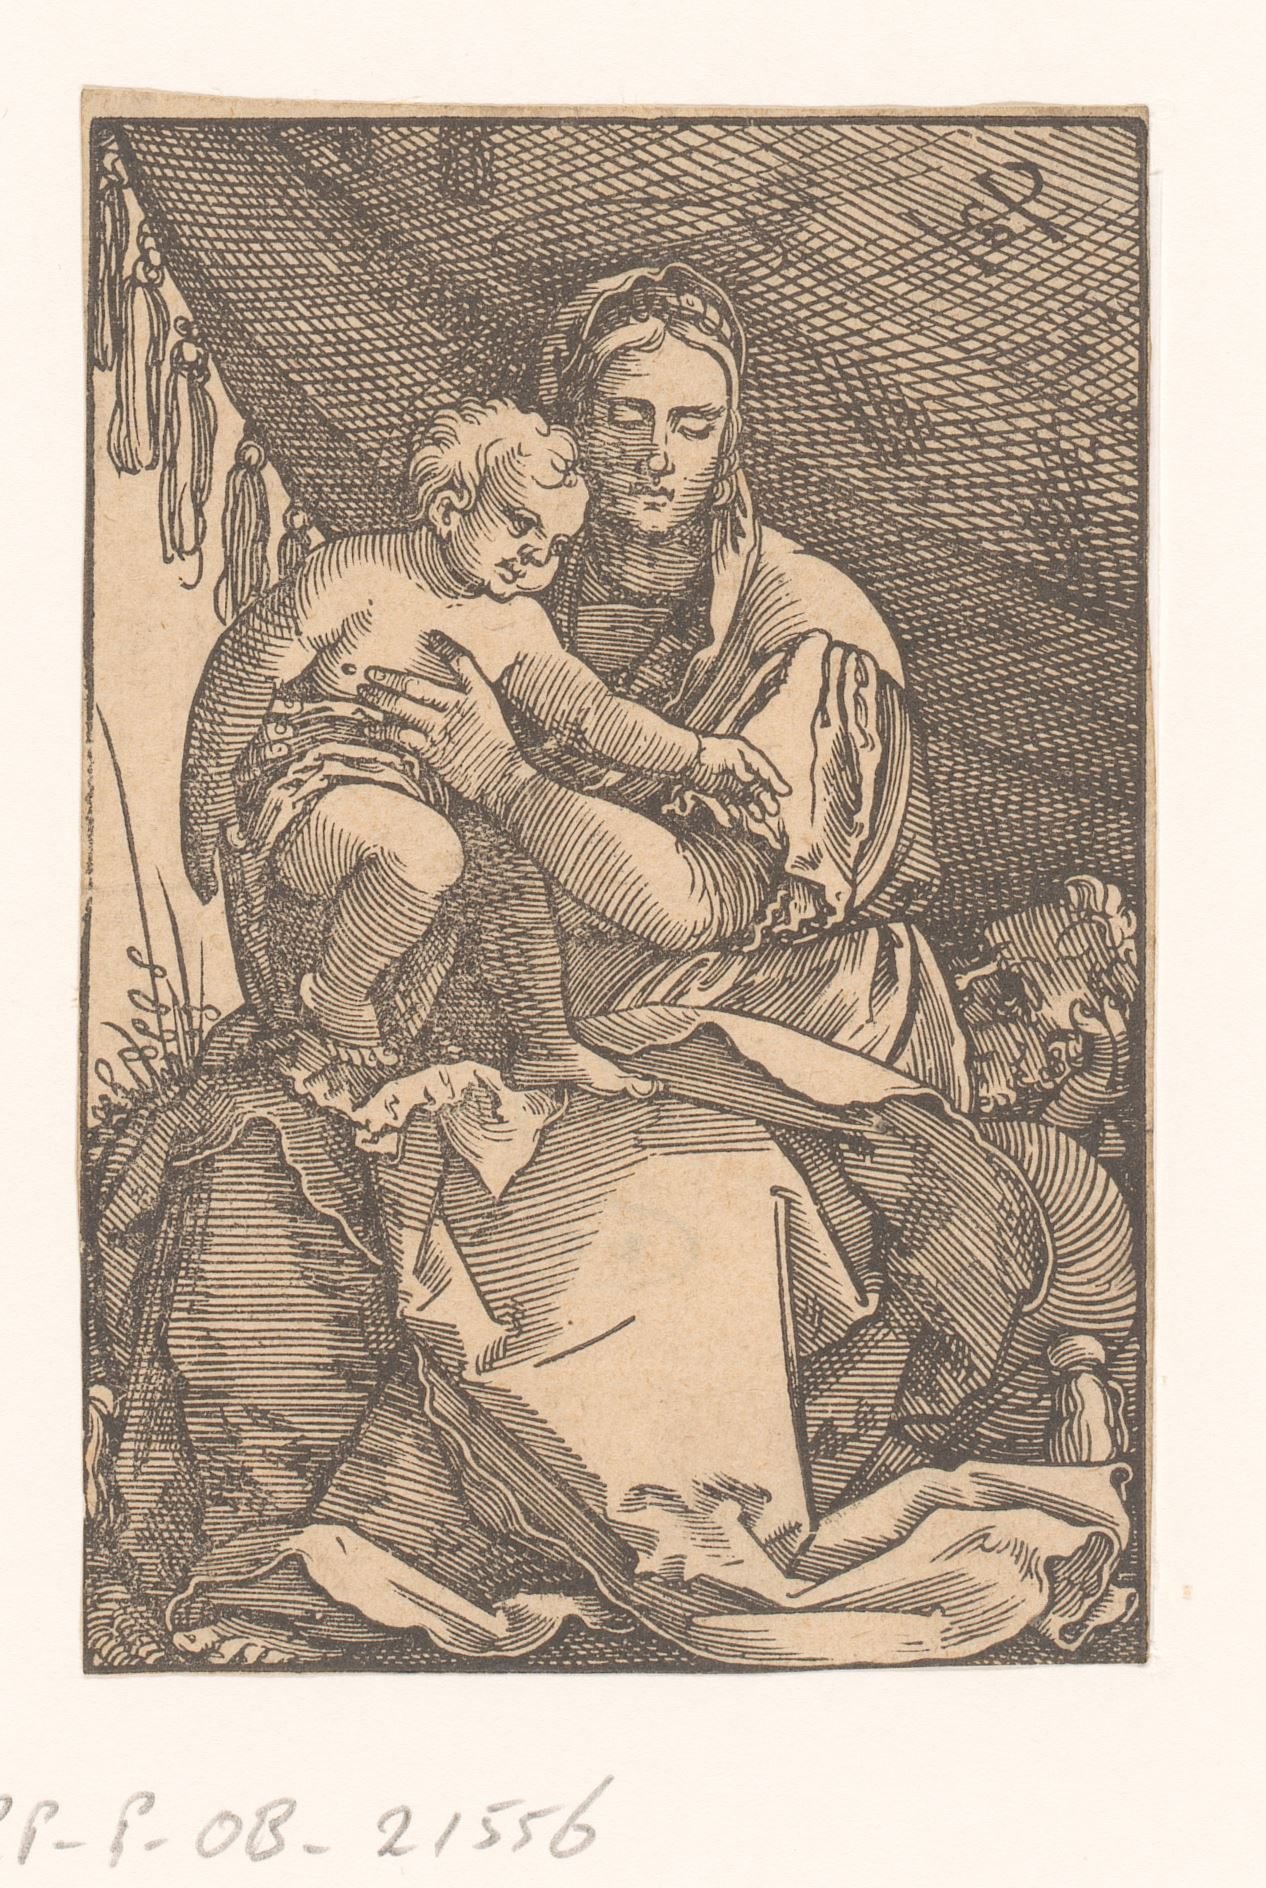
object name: print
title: Heilige familie zittend onder een doek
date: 1510-1550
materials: paper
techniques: woodcut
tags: holy family (alone), 'trinitas terrestris'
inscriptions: collector's mark: Lugt 2228